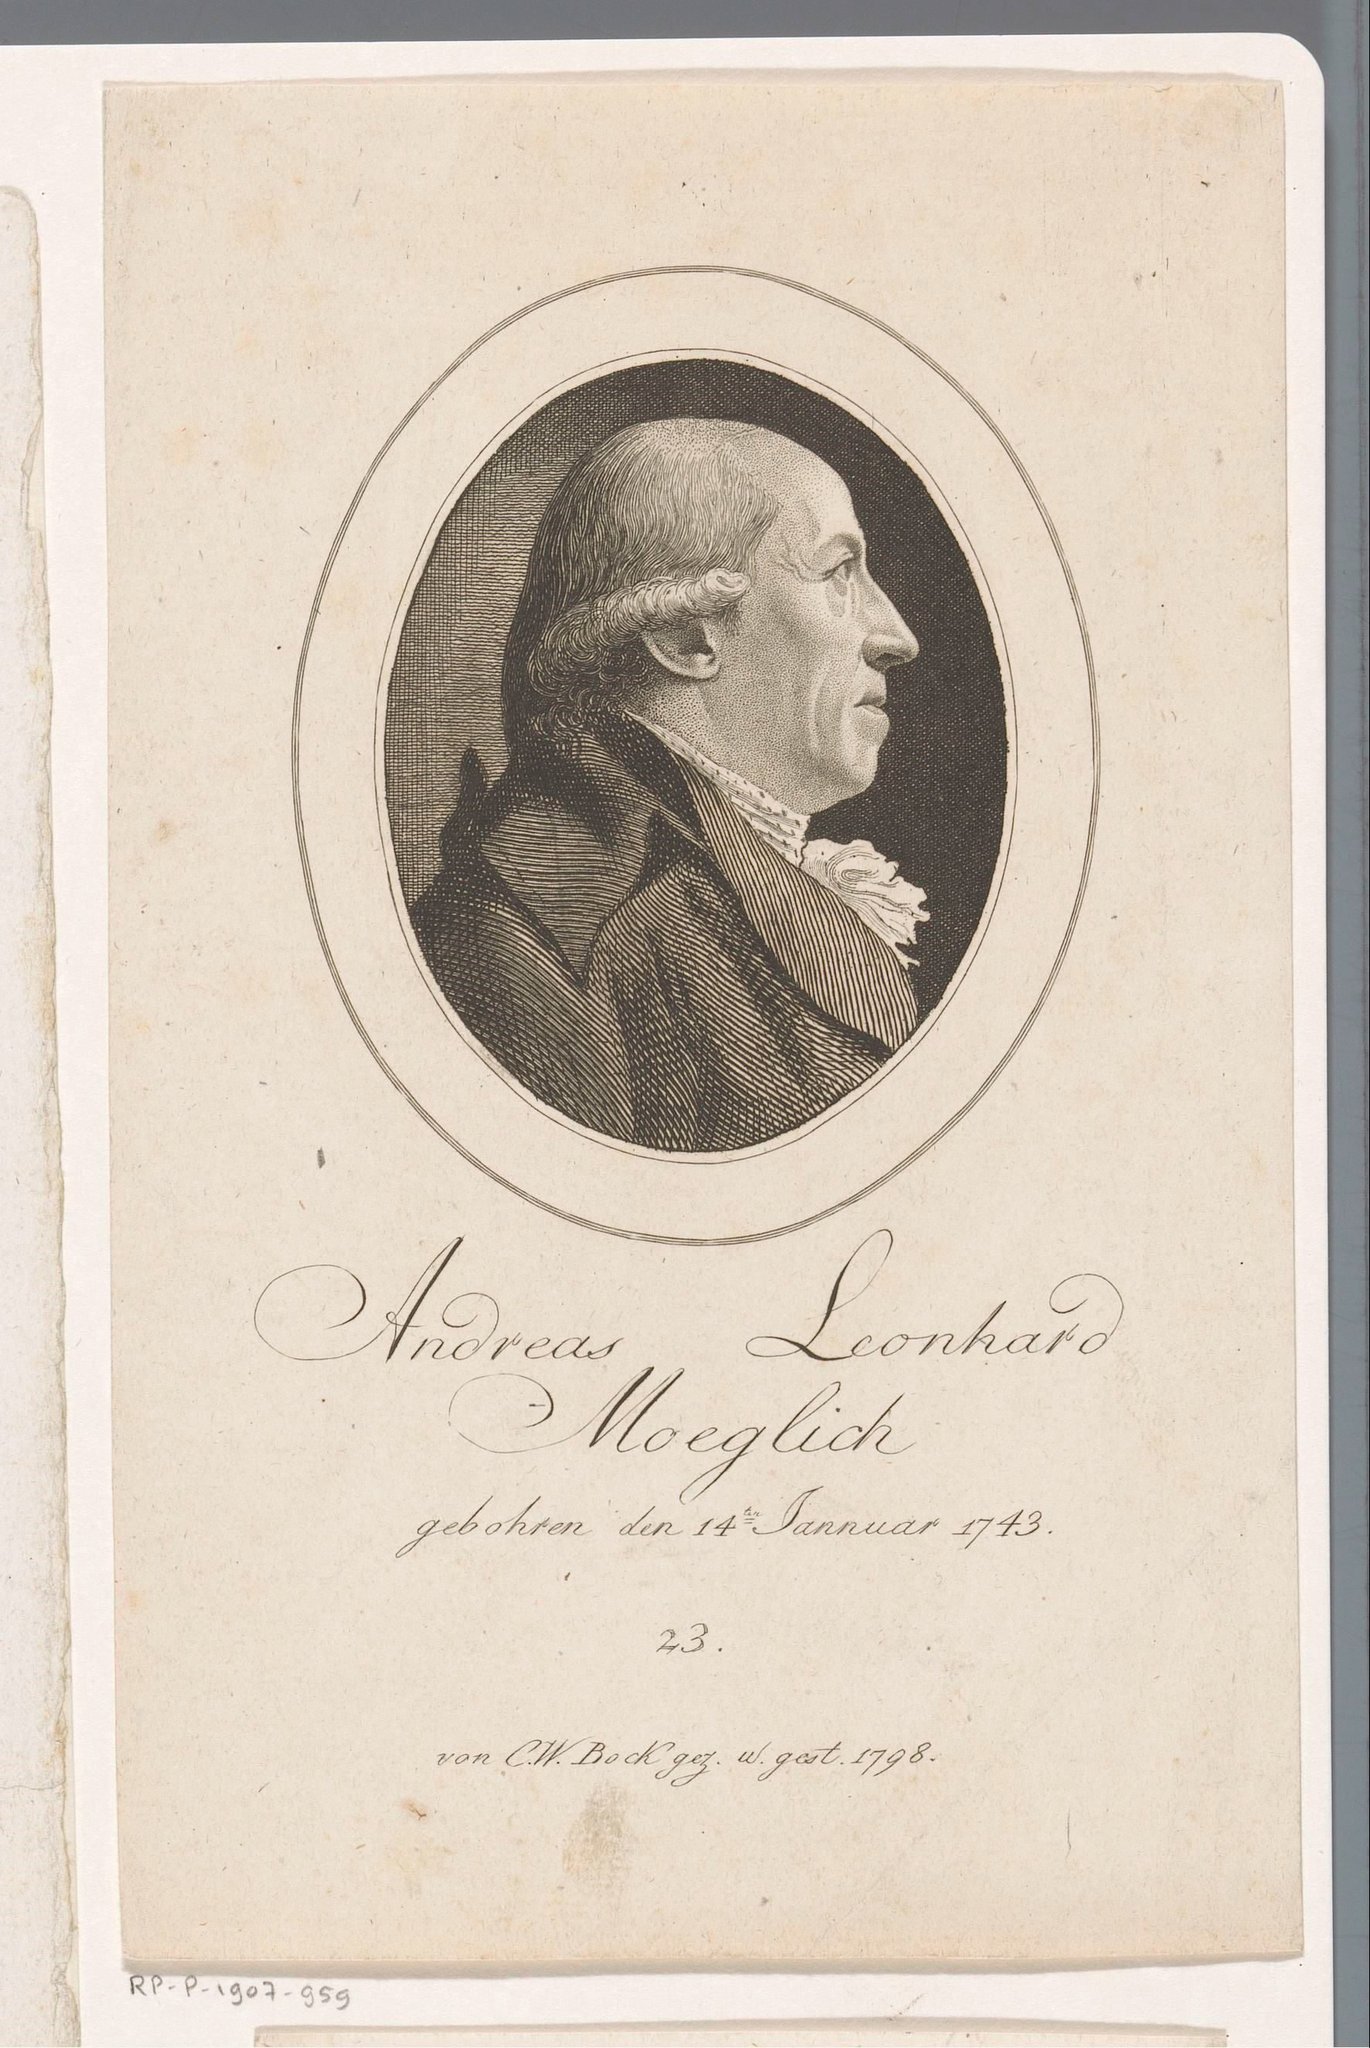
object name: print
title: Portret van Andreas Leonhard Moeglich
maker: christoph wilhelm bock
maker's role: print maker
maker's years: 1755-1836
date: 1798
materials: paper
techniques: engraving, etching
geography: nuremberg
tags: print maker, andreas leonhard moeglich, portrait, self-portrait of artist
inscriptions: collector's mark: Lugt 2228